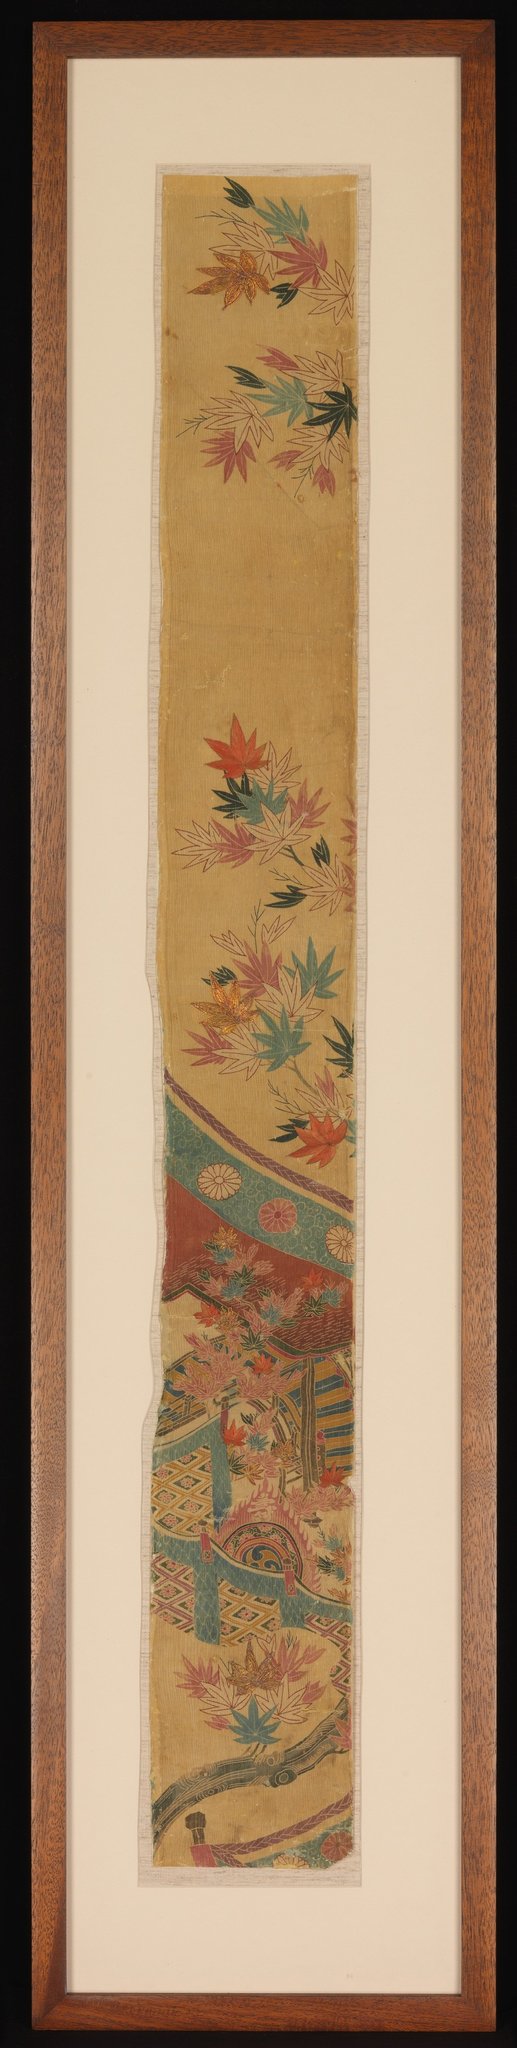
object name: piece from a kosode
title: Piece from a Robe (Kosode) with Maple Leaves, Curtain, and Large Drum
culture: japanese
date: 1701-1800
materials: metal thread, silk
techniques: dyeing, embroidery, painting, resist